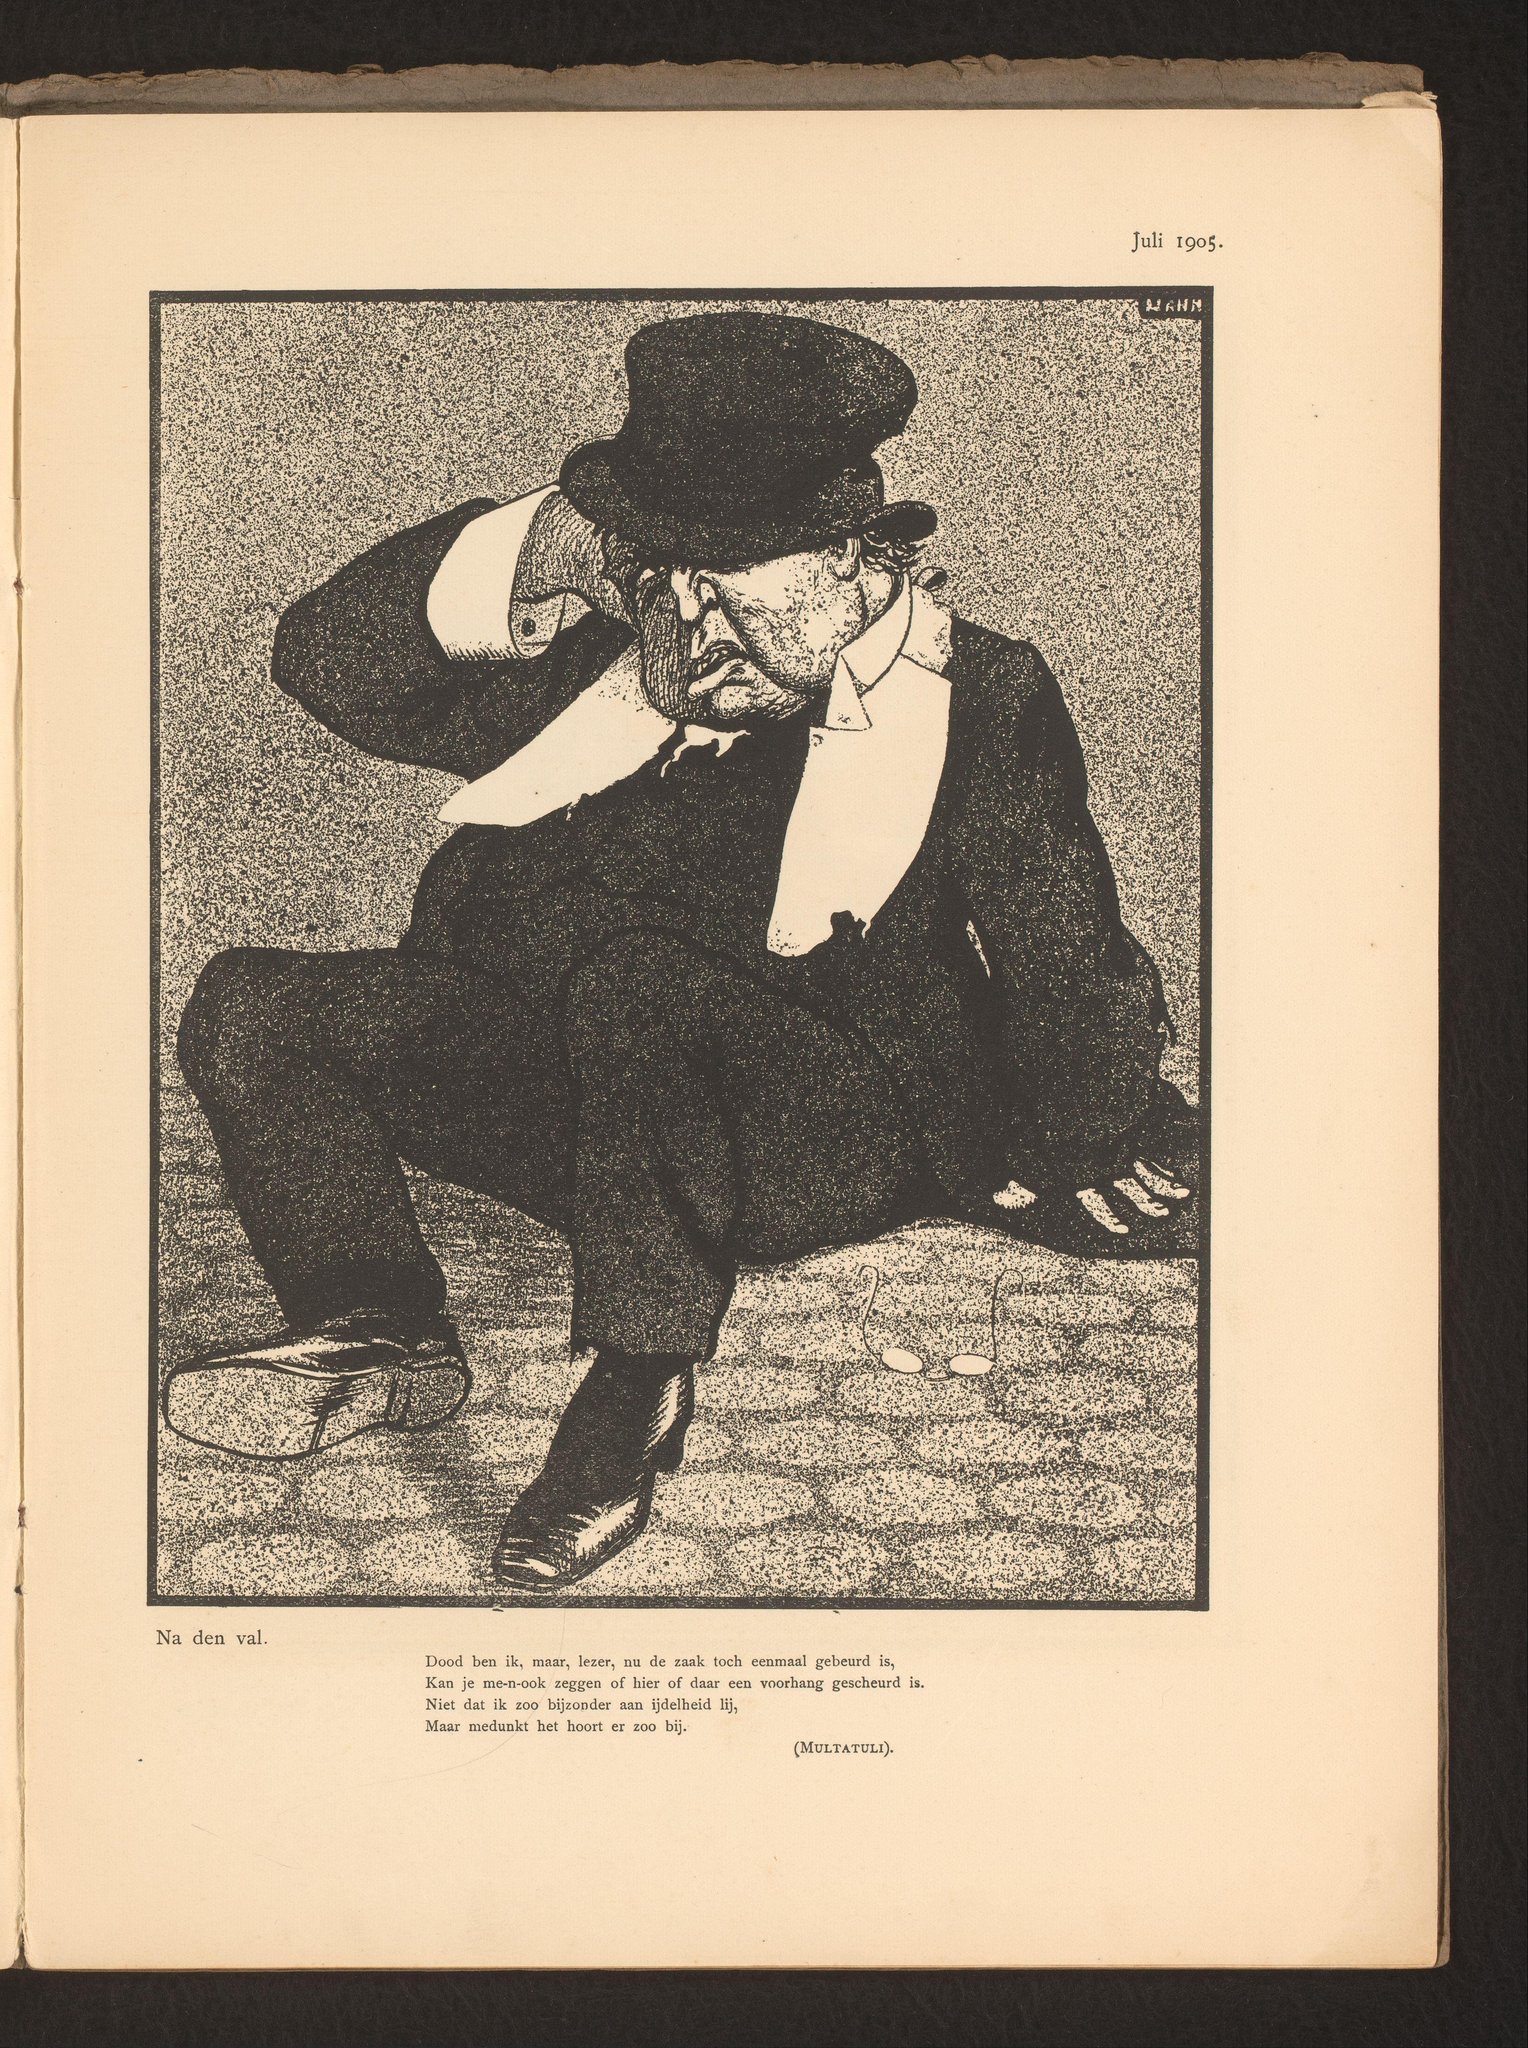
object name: cartoon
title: Na den val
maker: albert hahn (i)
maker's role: draughtsman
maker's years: 1877-1918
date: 1905-1907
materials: paper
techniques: autotype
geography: netherlands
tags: the hague, abraham kuyper, falling, political caricatures and satires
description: Abraham Kuyper, gevallen op straat, juli 1905. Onder de voorstelling een vierregelig vers van Multatuli. Onderdeel van het boek 'Albert Hahn Prenten', heruitgave van een selectie politieke prenten uit de periode 1902-1906.